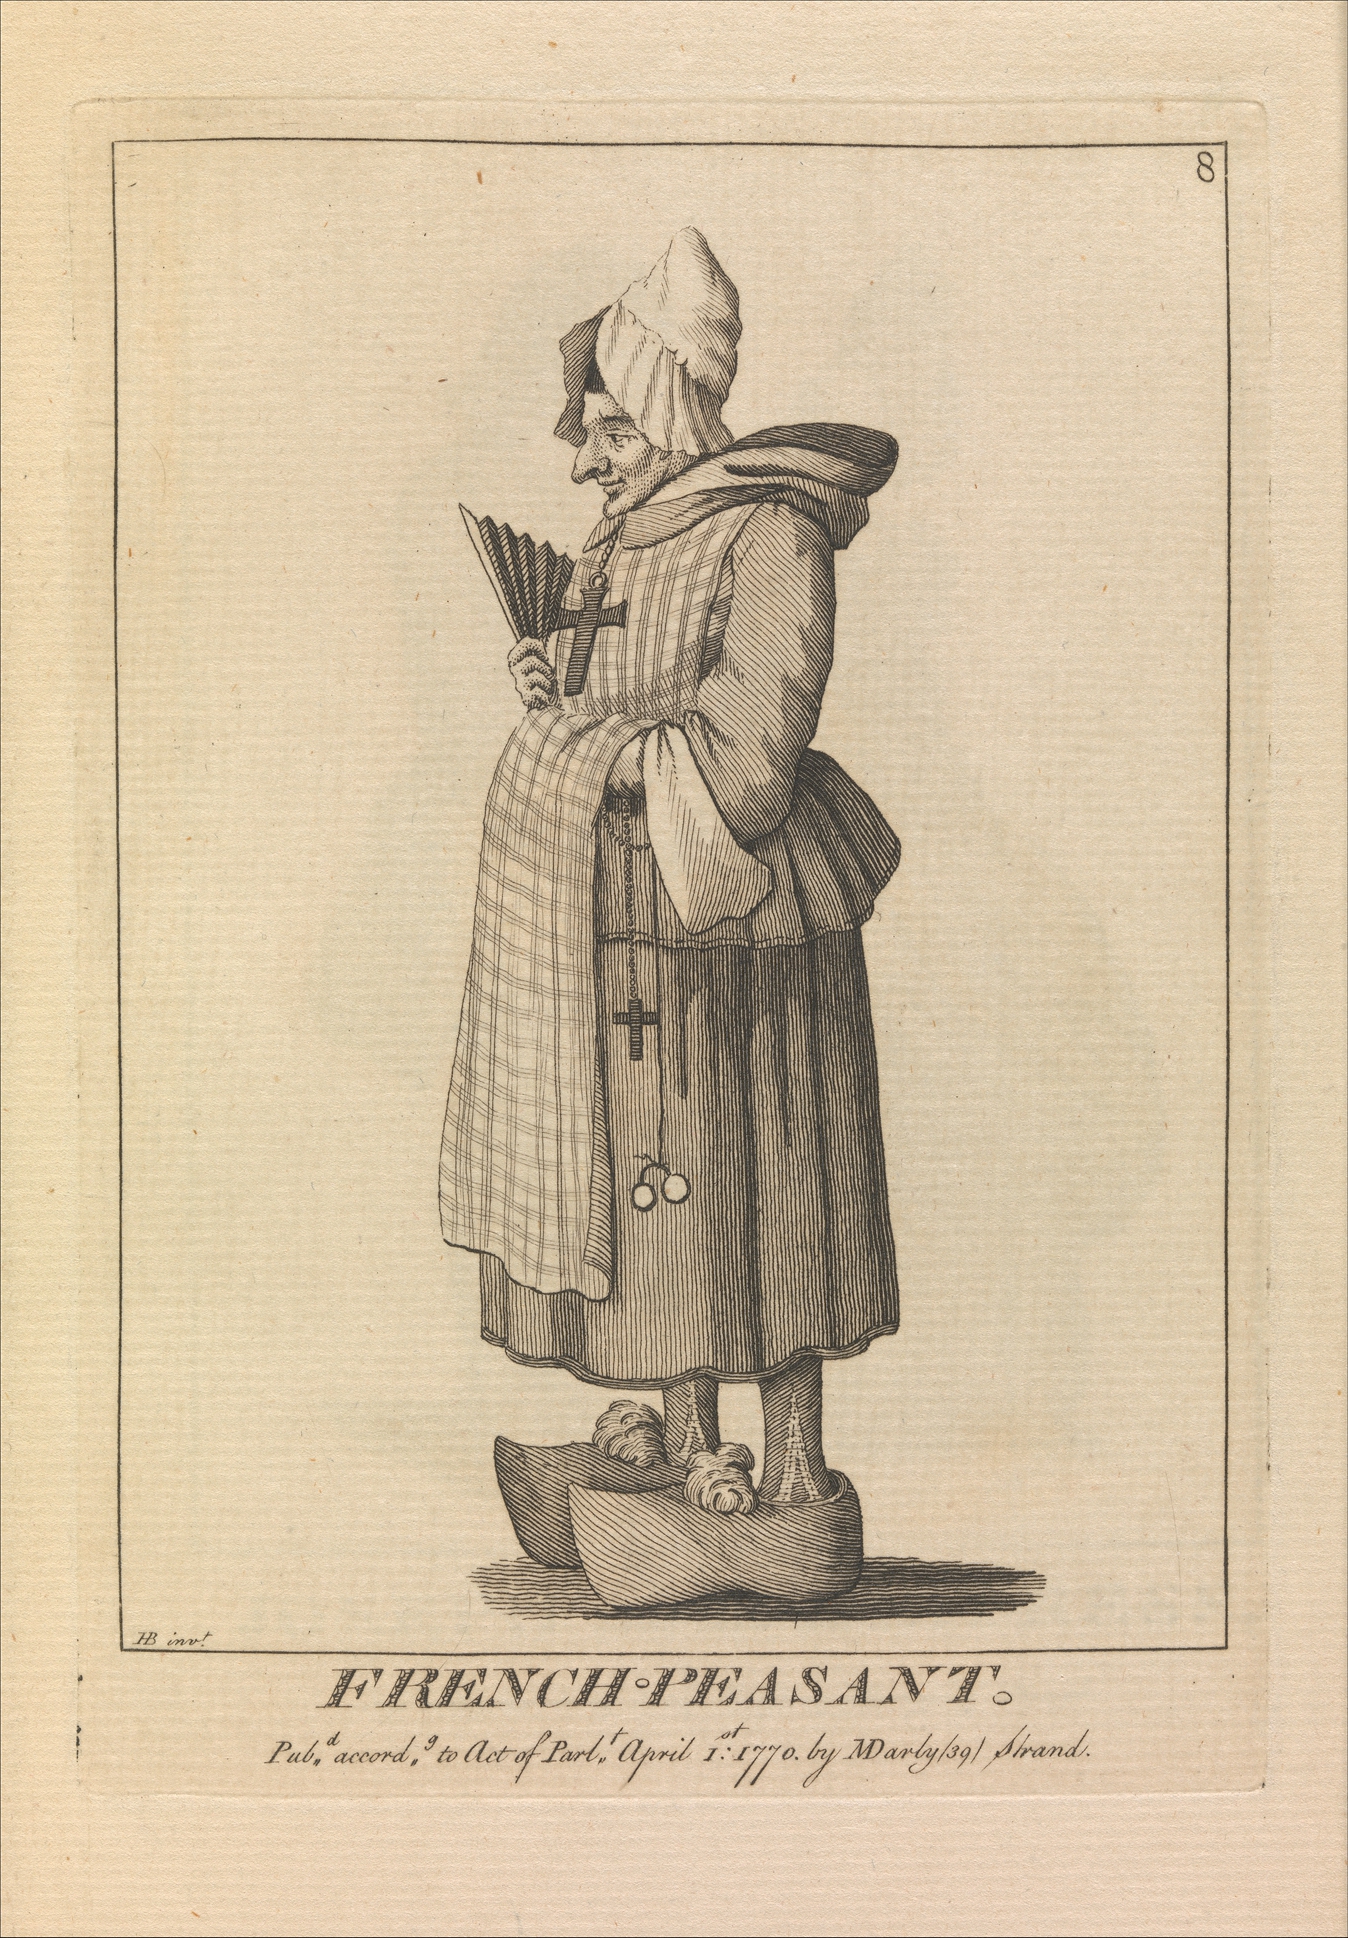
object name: print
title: French Peasant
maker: henry william bunbury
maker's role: artist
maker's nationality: british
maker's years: 1750-1811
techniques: etching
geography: london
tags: women,cross,farmers